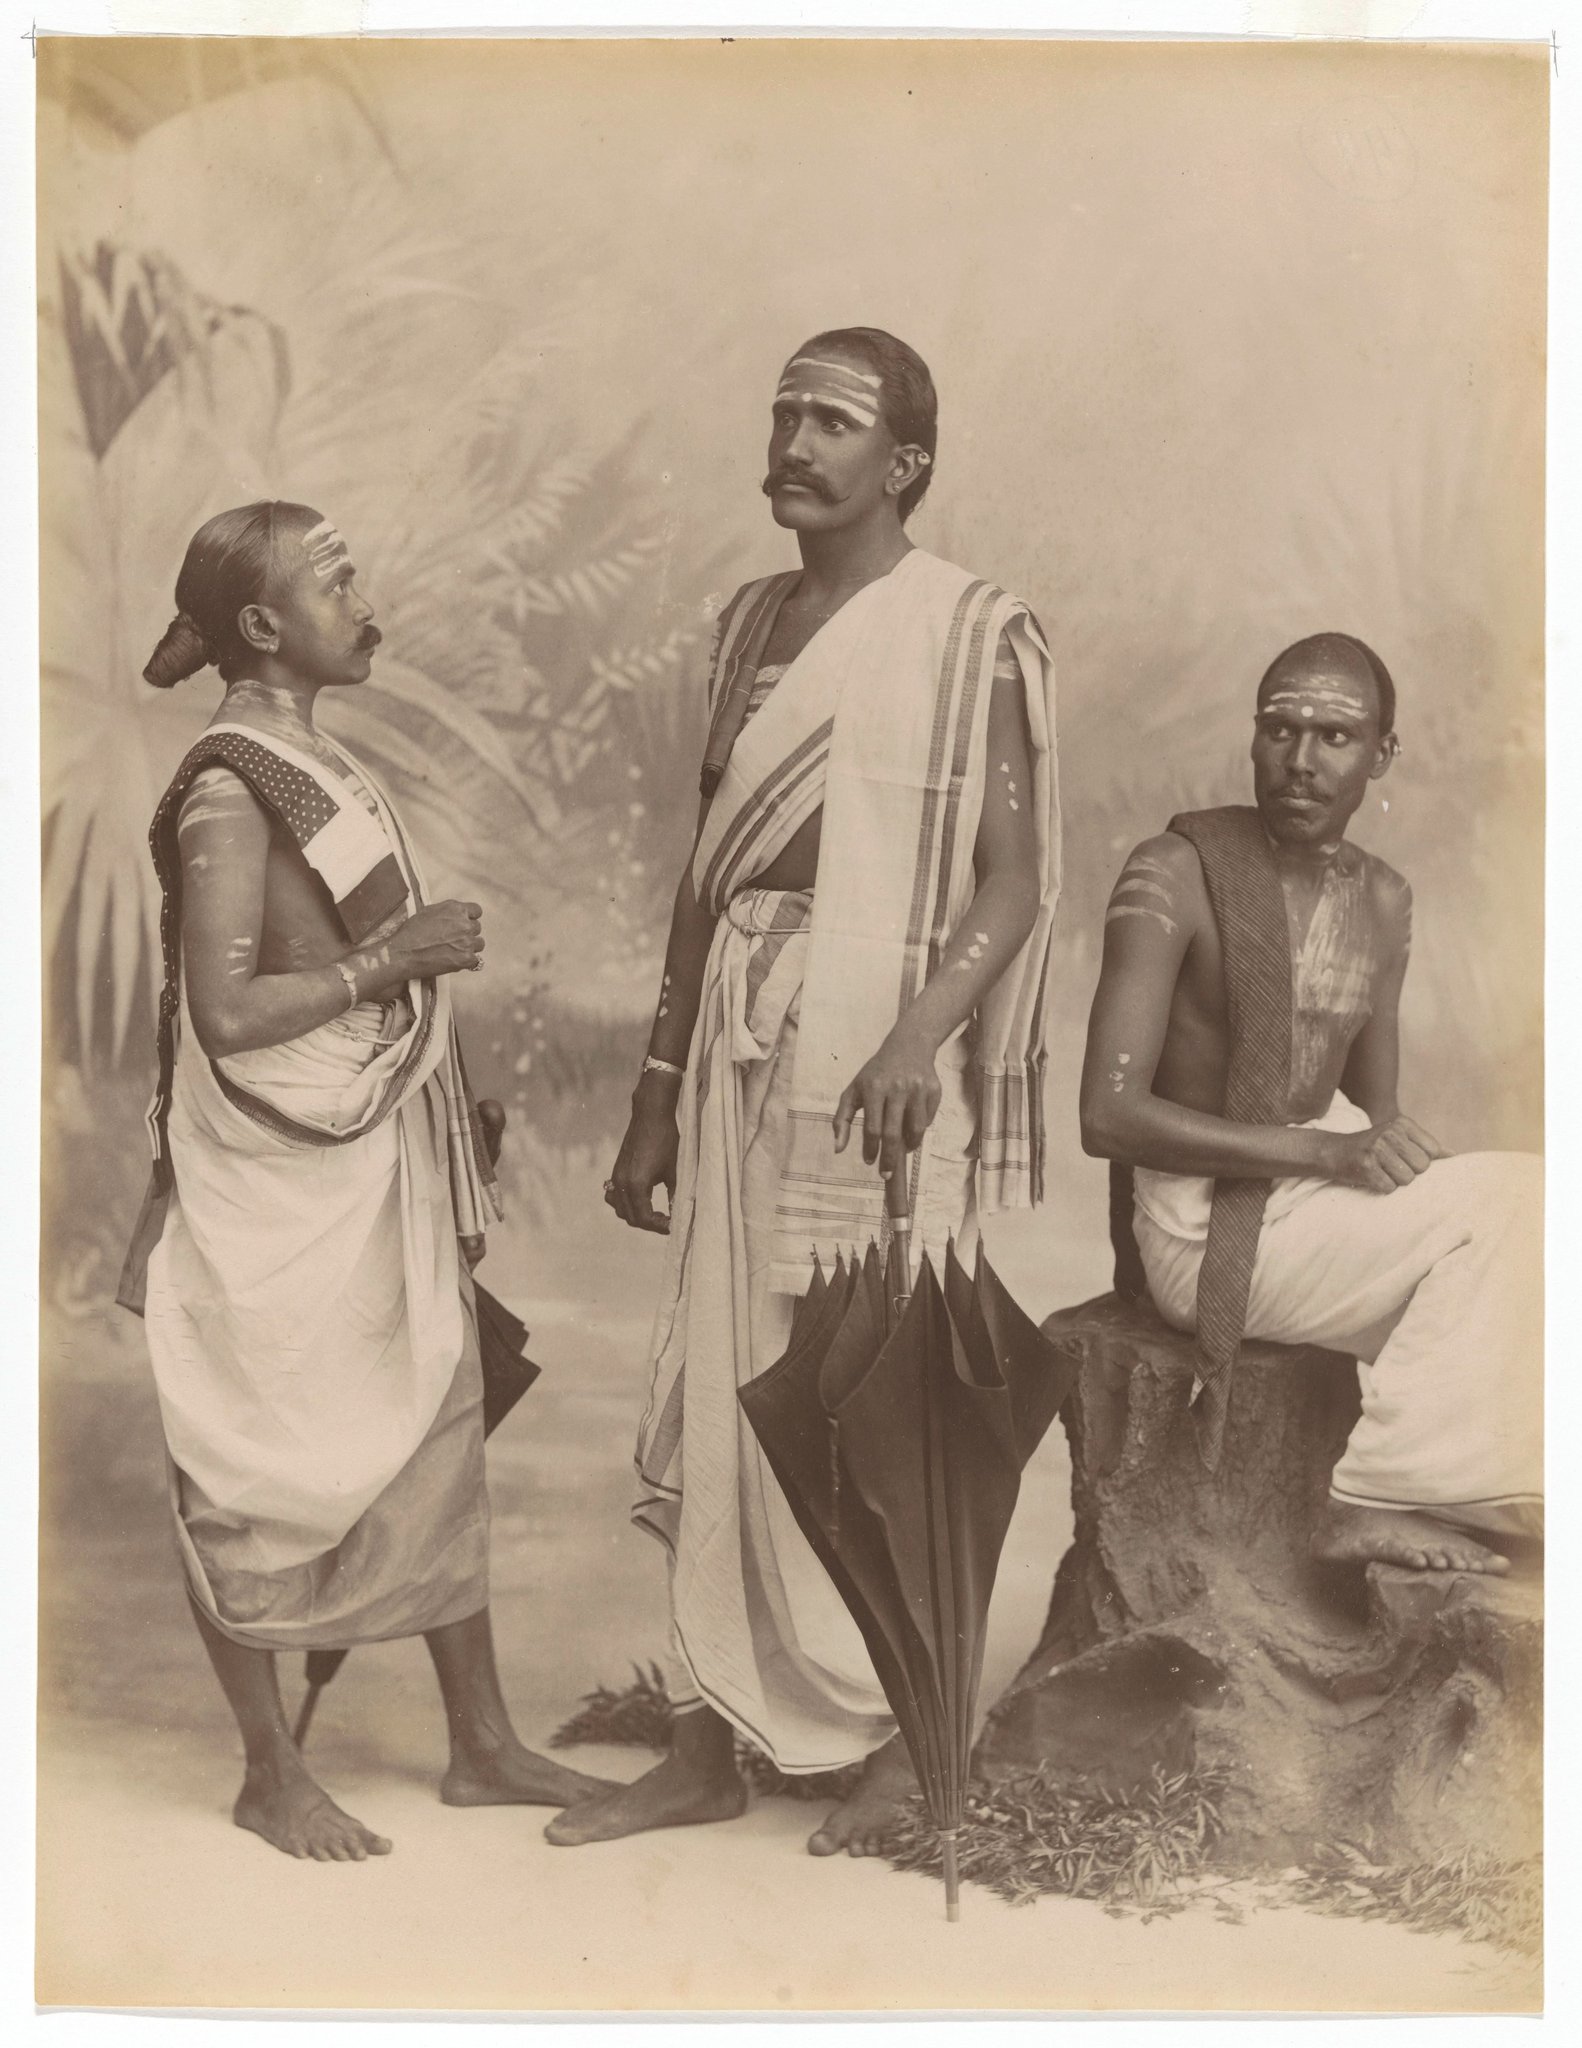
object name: photograph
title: Studio portrait of three unknown Tamil priests, Sri Lanka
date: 1876-1893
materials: paper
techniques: albumen print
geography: sri lanka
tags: priest ~ non-christian religions, anonymous historical persons portrayed in a group, in a group-portrait, sri lanka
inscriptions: number: ‘44’, inscription: ‘Tamil Barhmins’